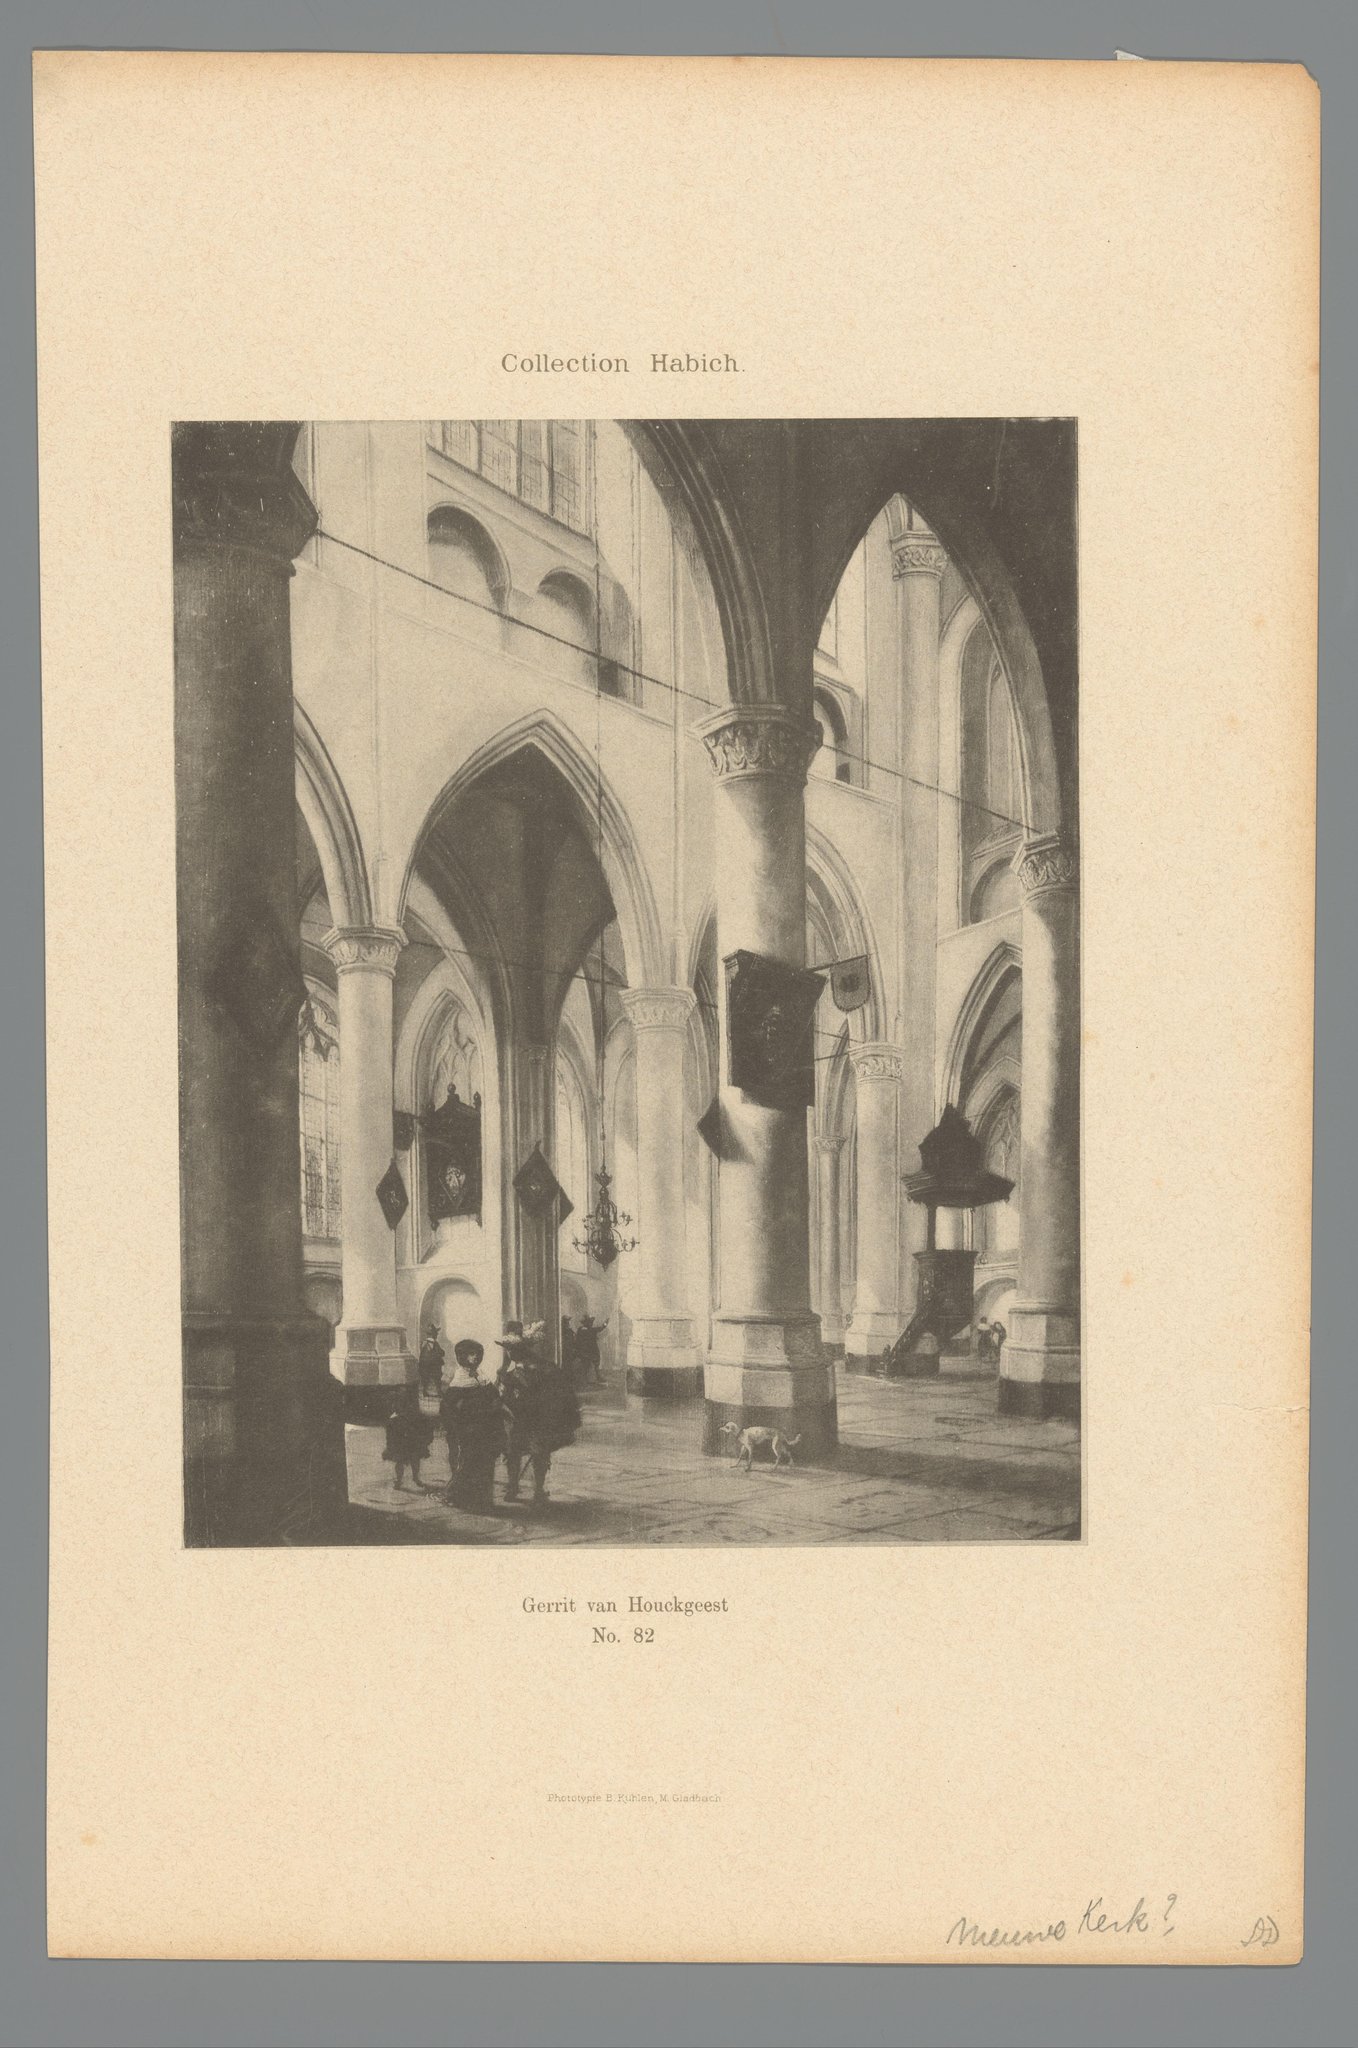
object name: photomechanical print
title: Reproductie van een schilderij van Gerard Houckgeest met het interieur van de Nieuwe Kerk te Delft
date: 1880-1910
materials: paper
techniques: photograph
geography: mönchengladbach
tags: interior of church